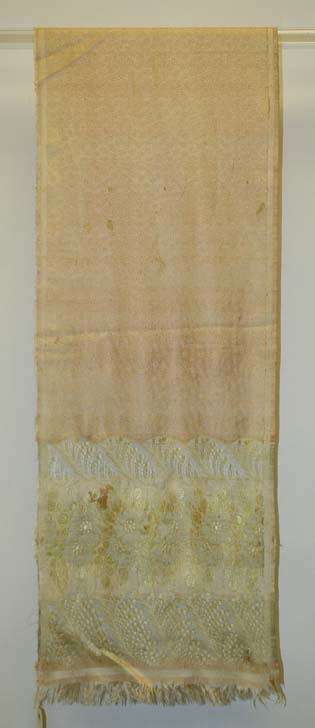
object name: scarf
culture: european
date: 1807-1810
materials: silk